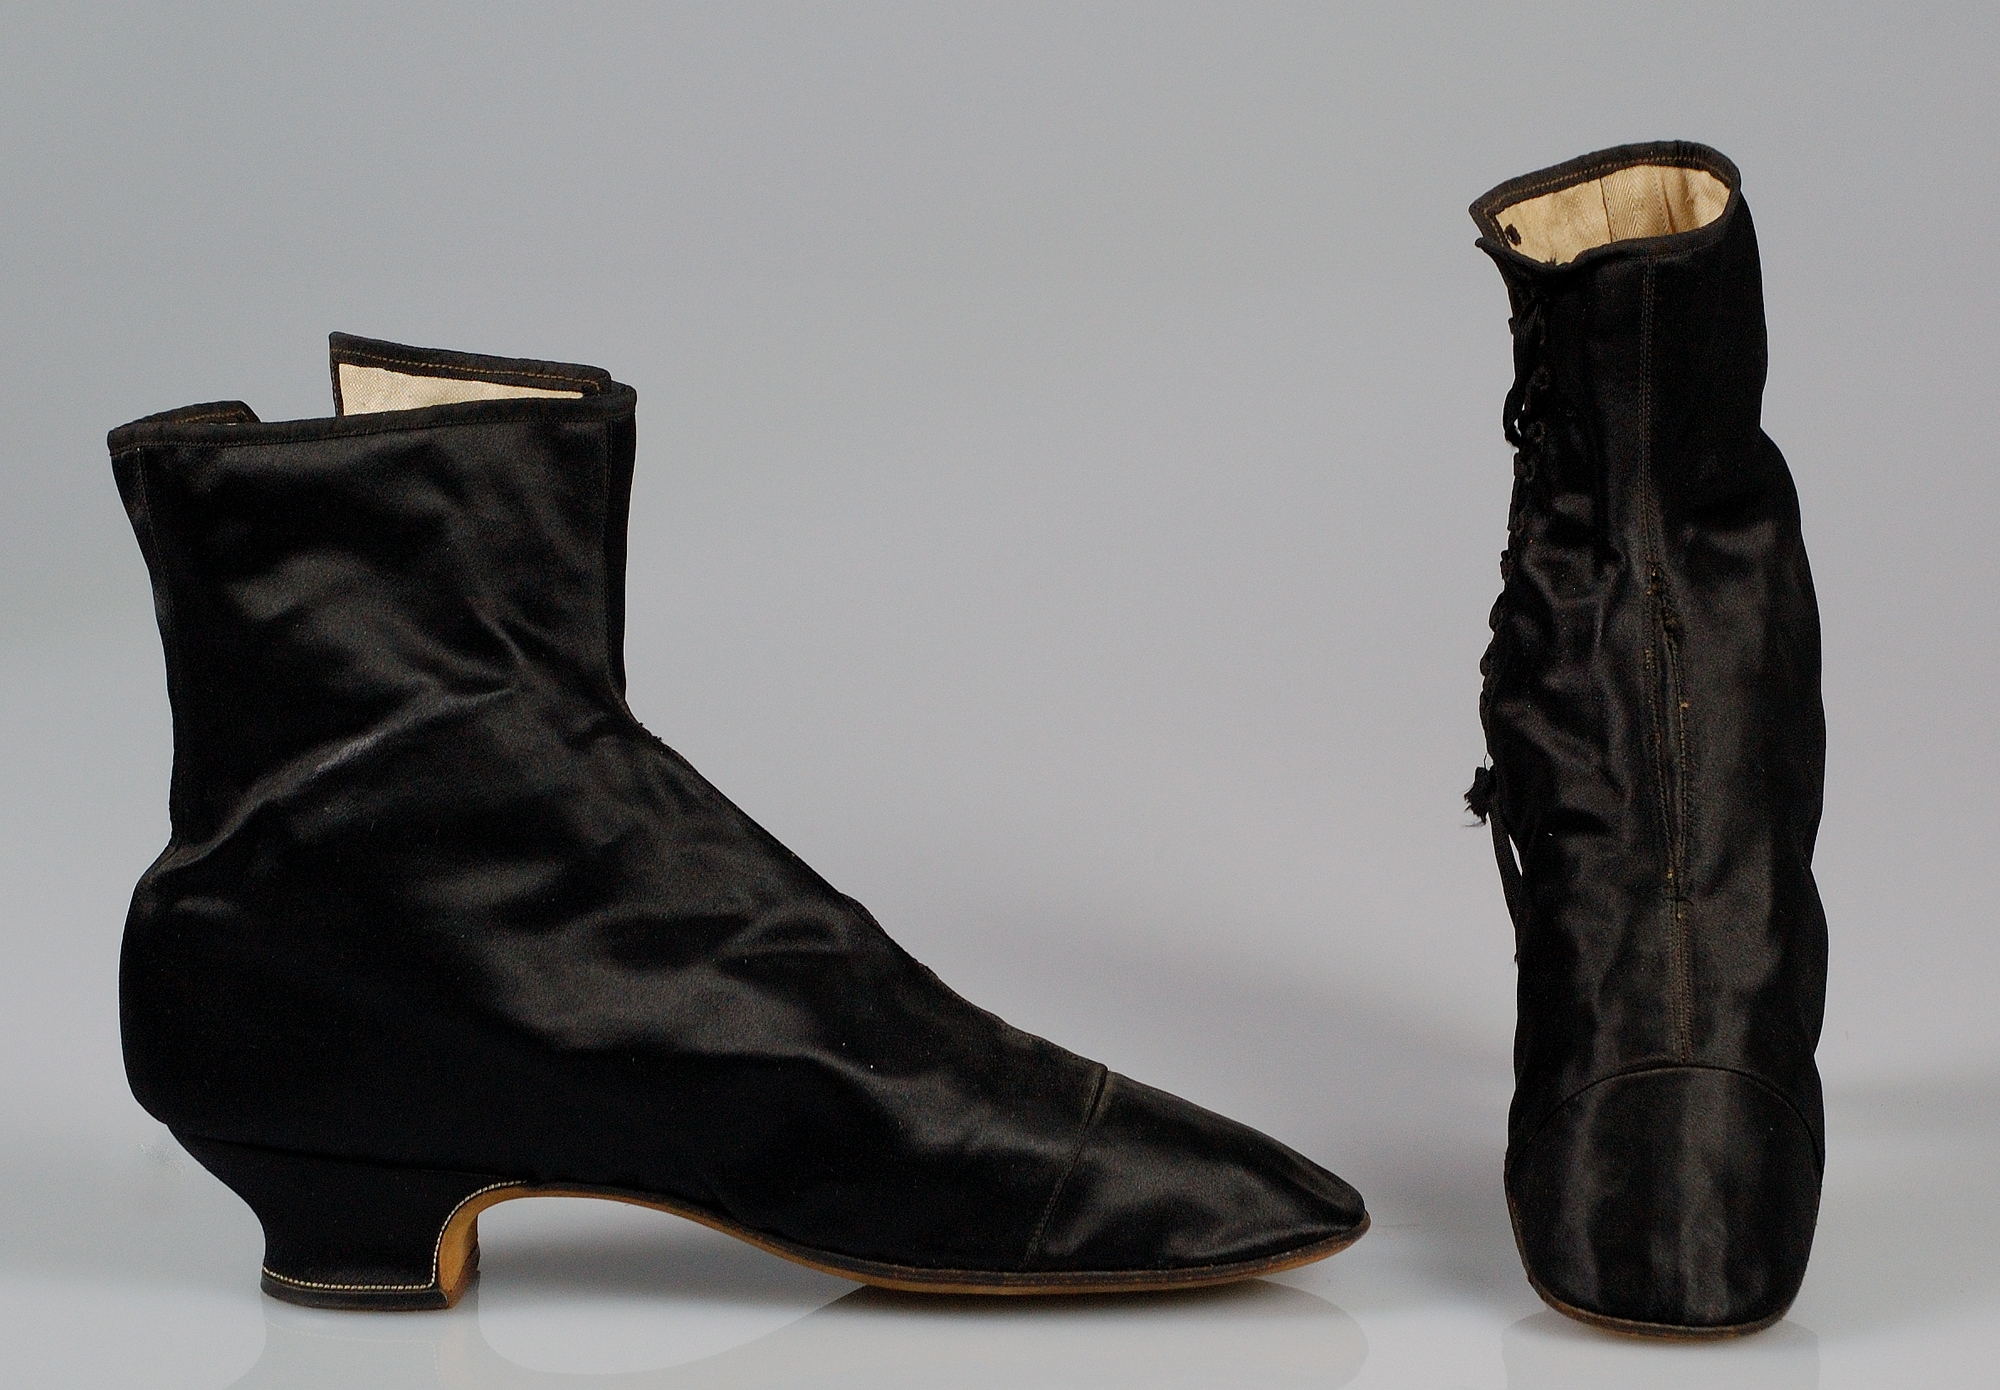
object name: evening boot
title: Evening boots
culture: french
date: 1865-1870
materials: silk